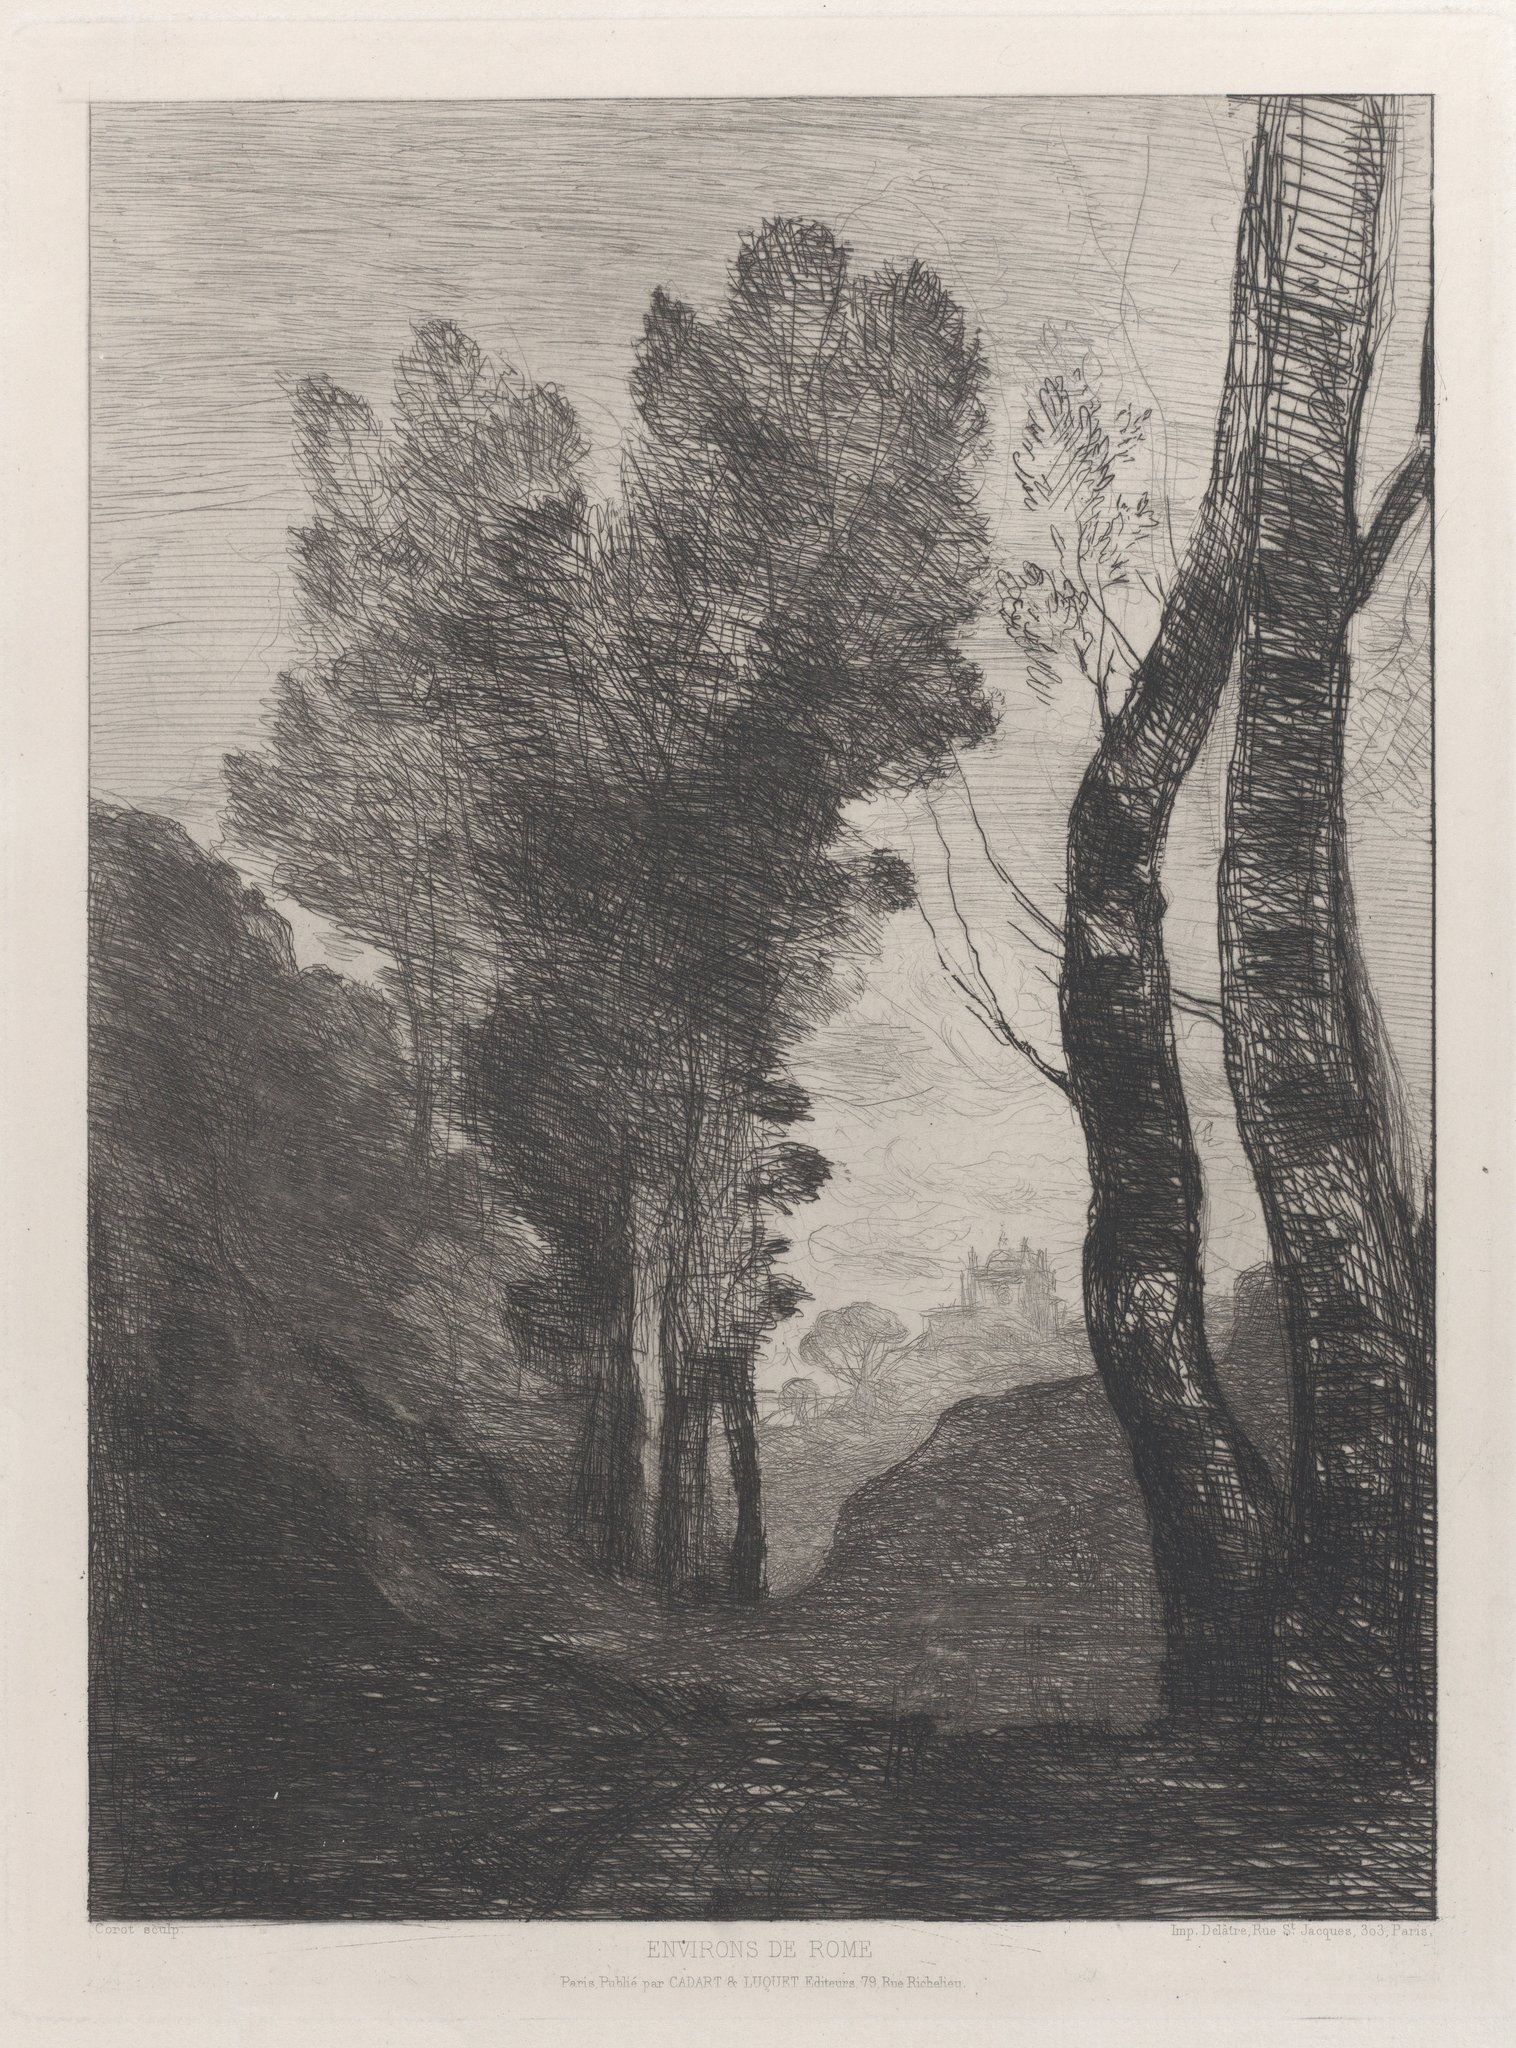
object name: print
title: Environs de Rome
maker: jean-baptiste-camille corot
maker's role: artist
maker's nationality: french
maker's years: 1796-1875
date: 1866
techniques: etching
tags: landscapes,trees